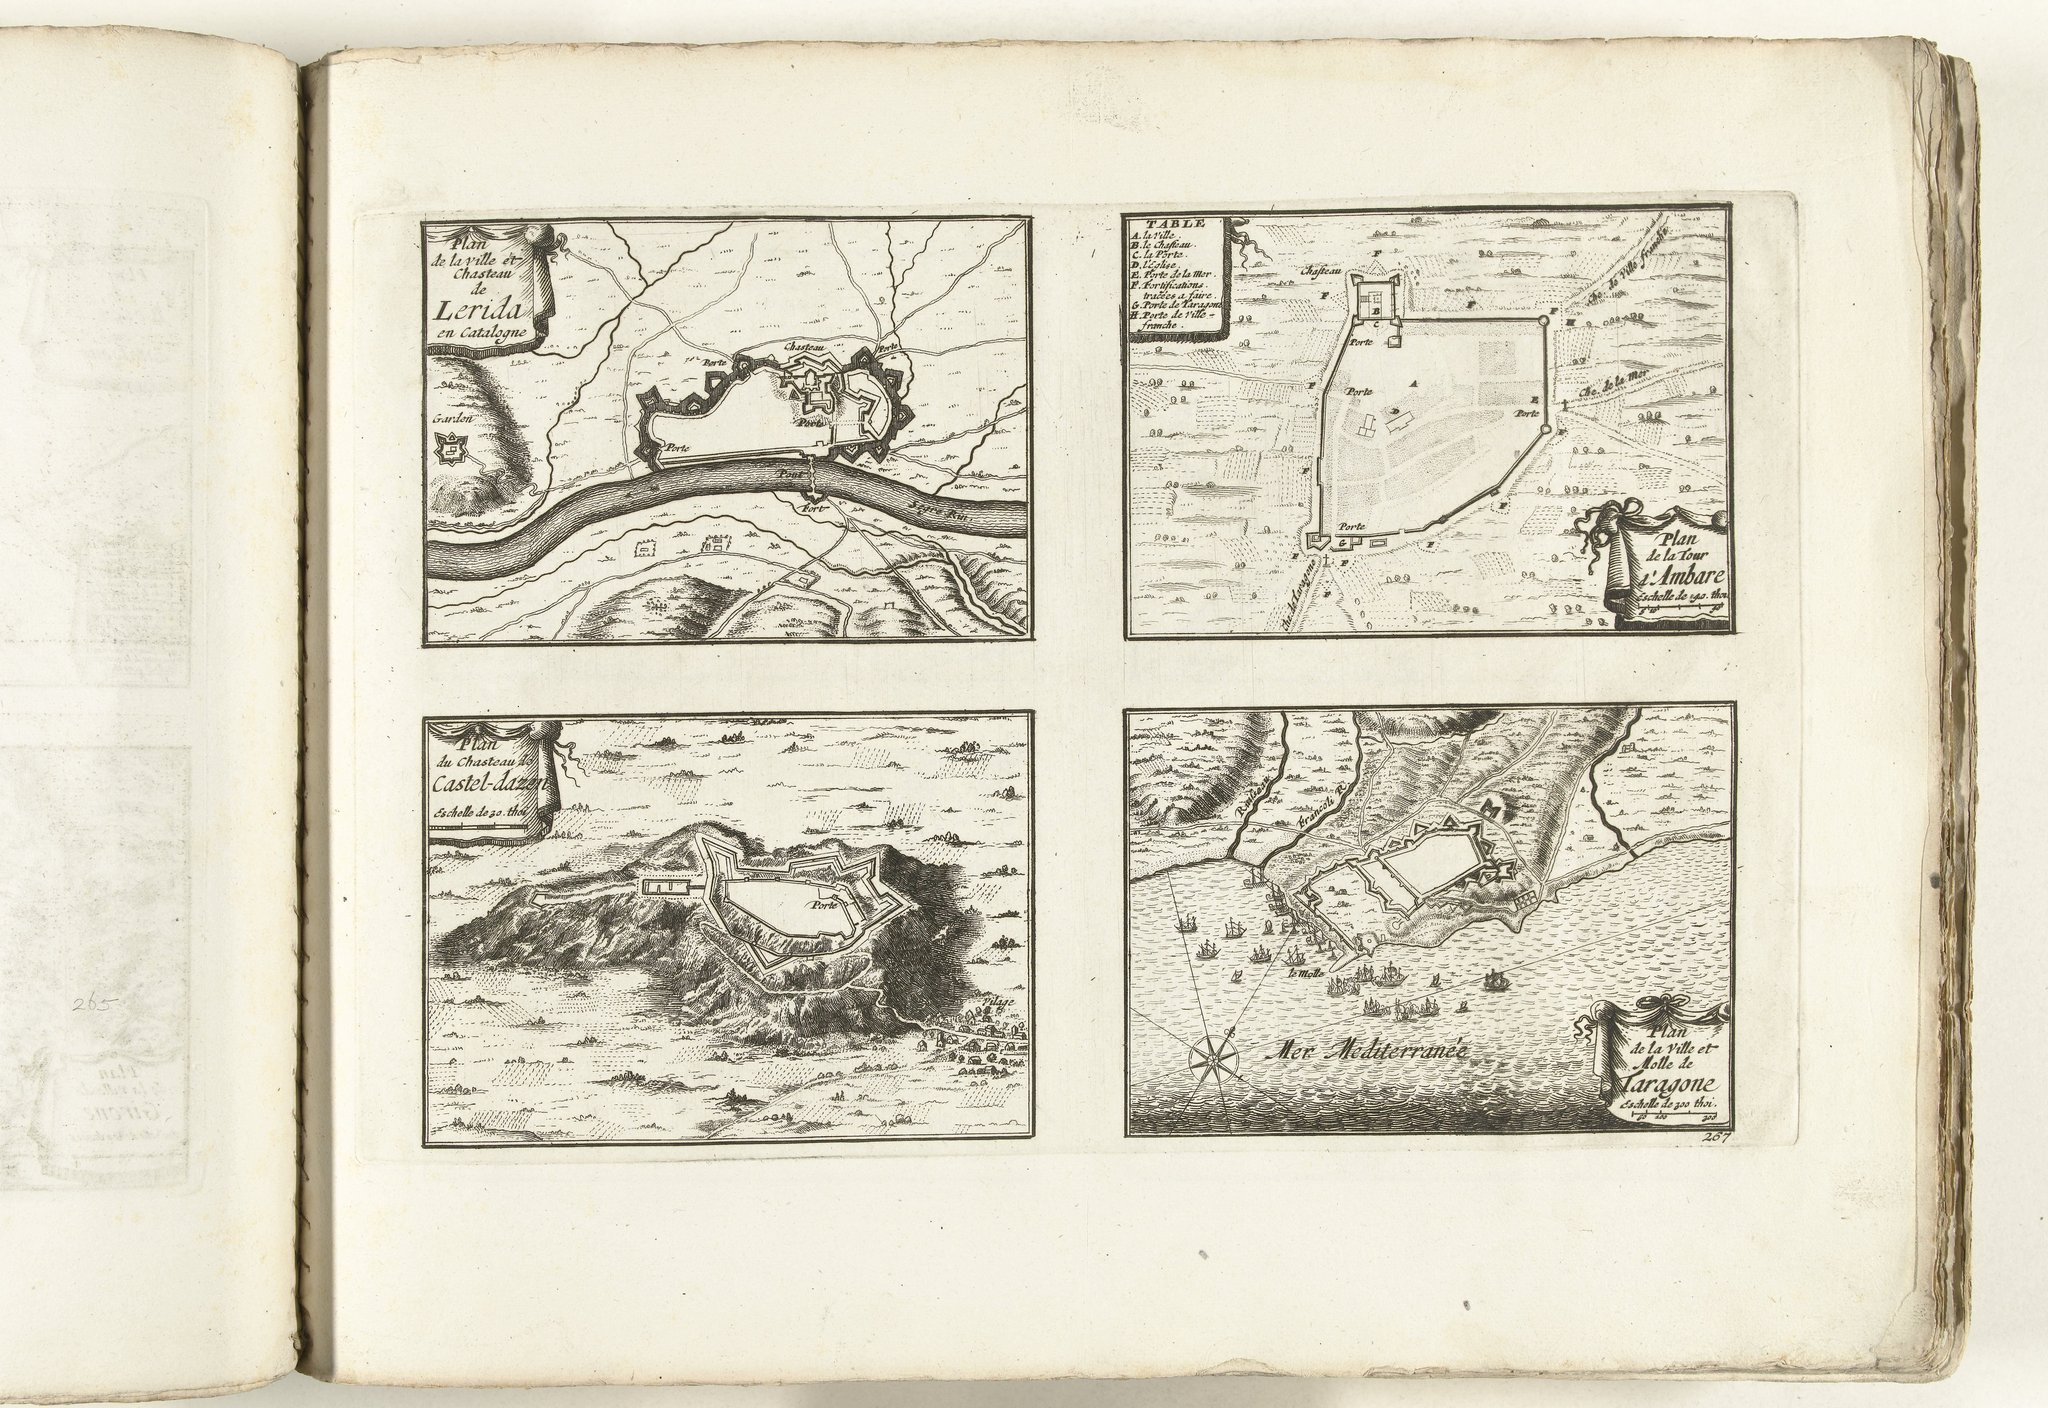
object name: map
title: Lerida / Ambare / Castel-dazen / Taragone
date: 1702-1703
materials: paper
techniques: etching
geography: amsterdam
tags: fortress, maps of cities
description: Blad met vier plattegronden van de versterkingen om Lérida, Tarragona en andere plaatsen in Catalonië. Plaat nr. 267 in het prentwerk bestaande in totaal uit 276 genummerde platen van vermaarde sterke steden en vestingen in het kader van de Spaanse Successieoorlog. Voor het merendeel zijn deze platen gekopieerd naar de anonieme Franse platen: in Les forces de l'Europe en in: Le theatre de la guerre, dans les Pays-Bas, beide oorspronkelijk uitgegeven door Nicolas de Fer te Parijs (1693-1697) in het kader van de Negenjarige Oorlog. Titels en opschriften in de plaat in het Frans.